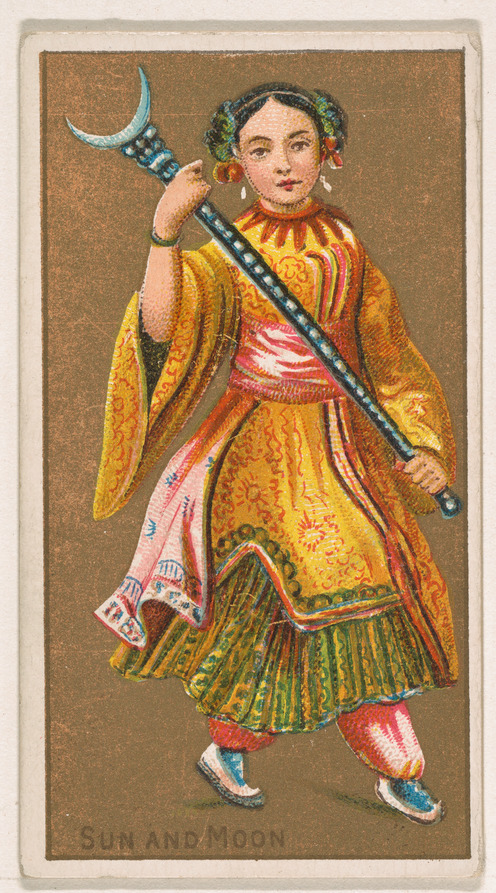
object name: print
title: Sun and Moon, from National Dances (N225, Type 1) issued by Kinney Bros.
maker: kinney brothers tobacco company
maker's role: publisher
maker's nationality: american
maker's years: 1869-2011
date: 1889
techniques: color lithograph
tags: dance,women,dancers